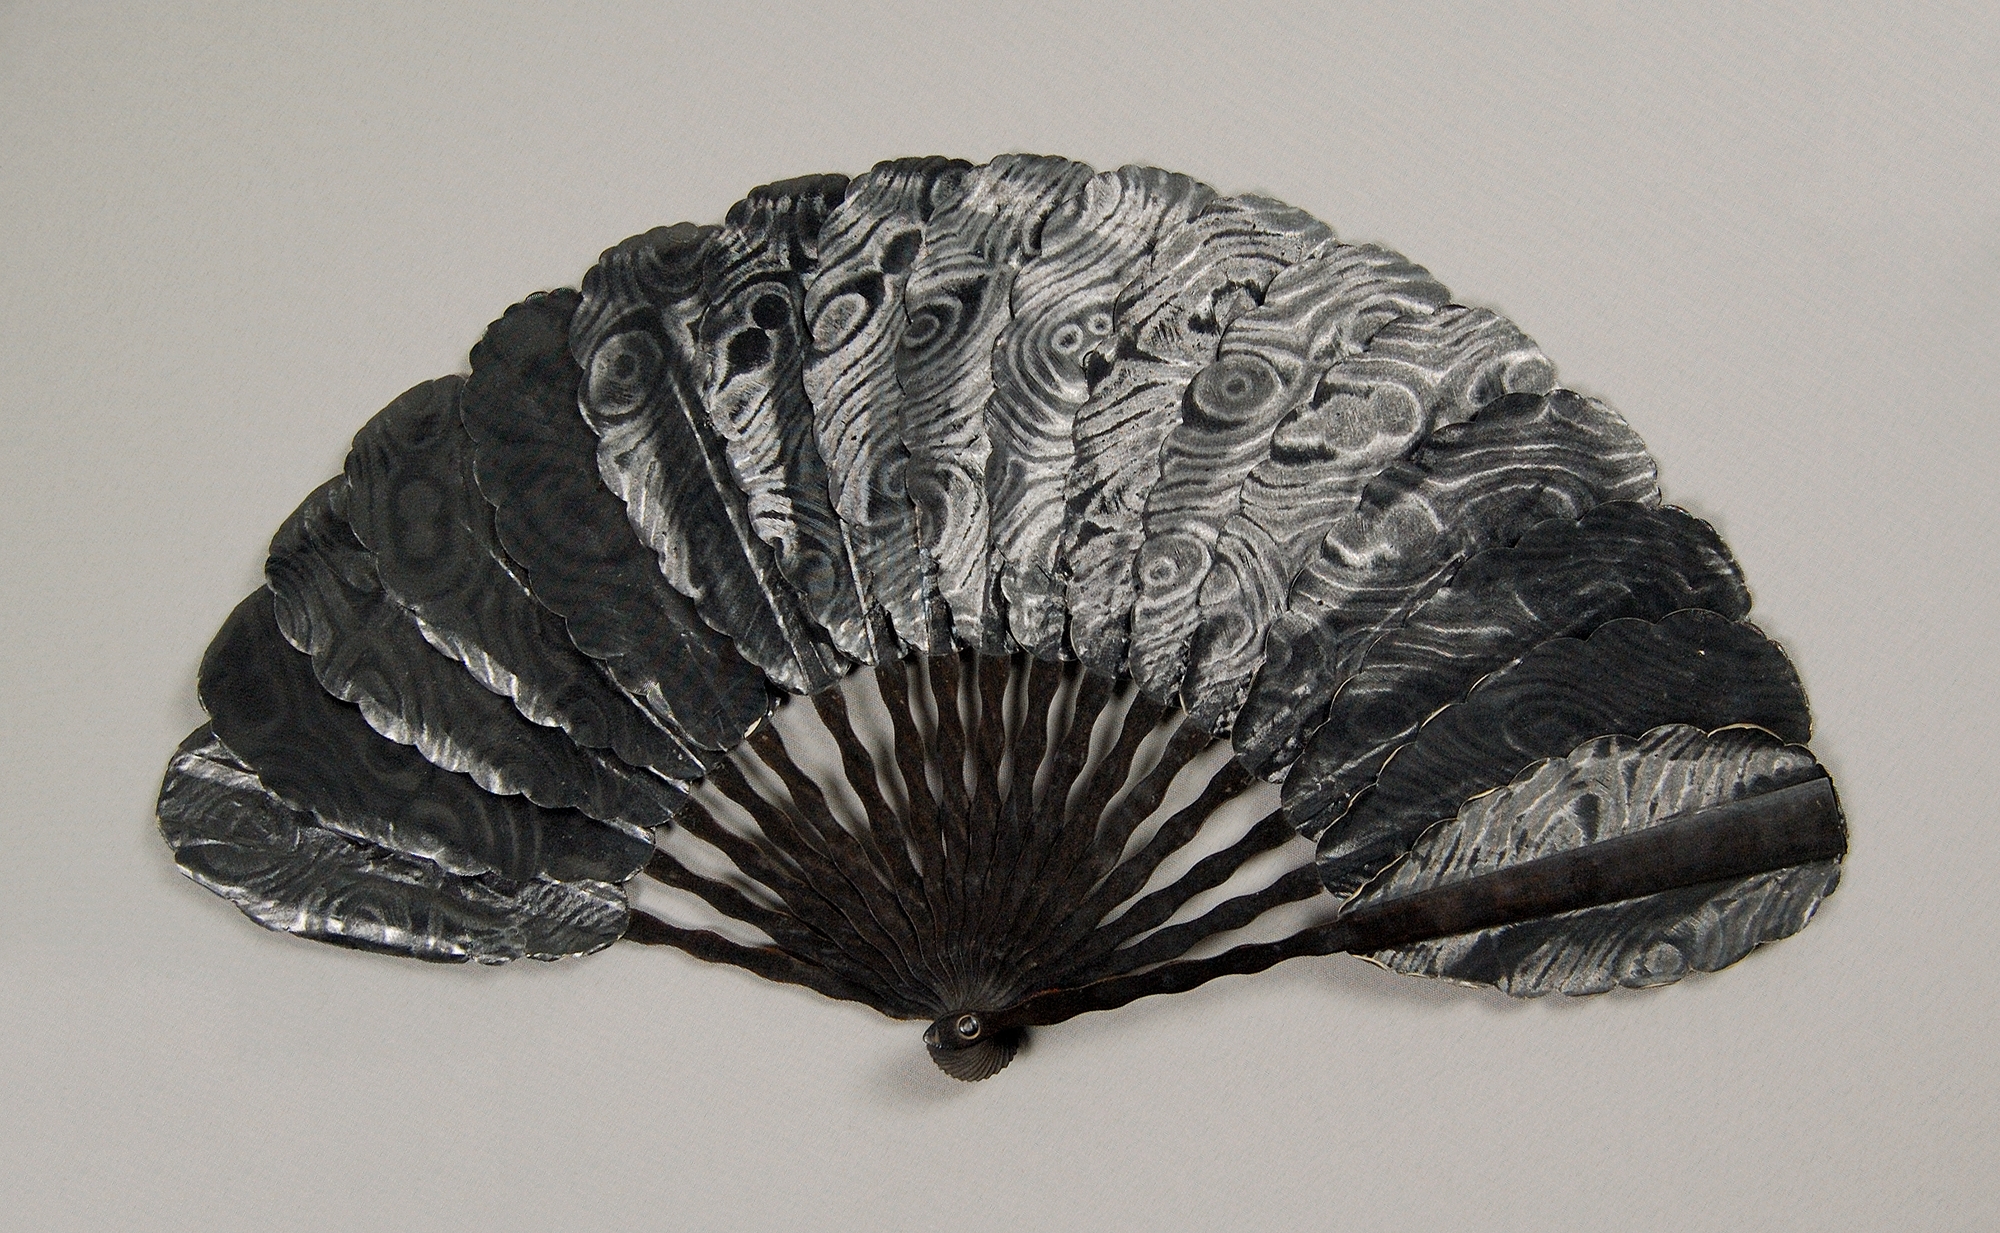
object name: fan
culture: american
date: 1855-1865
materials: paper, wood